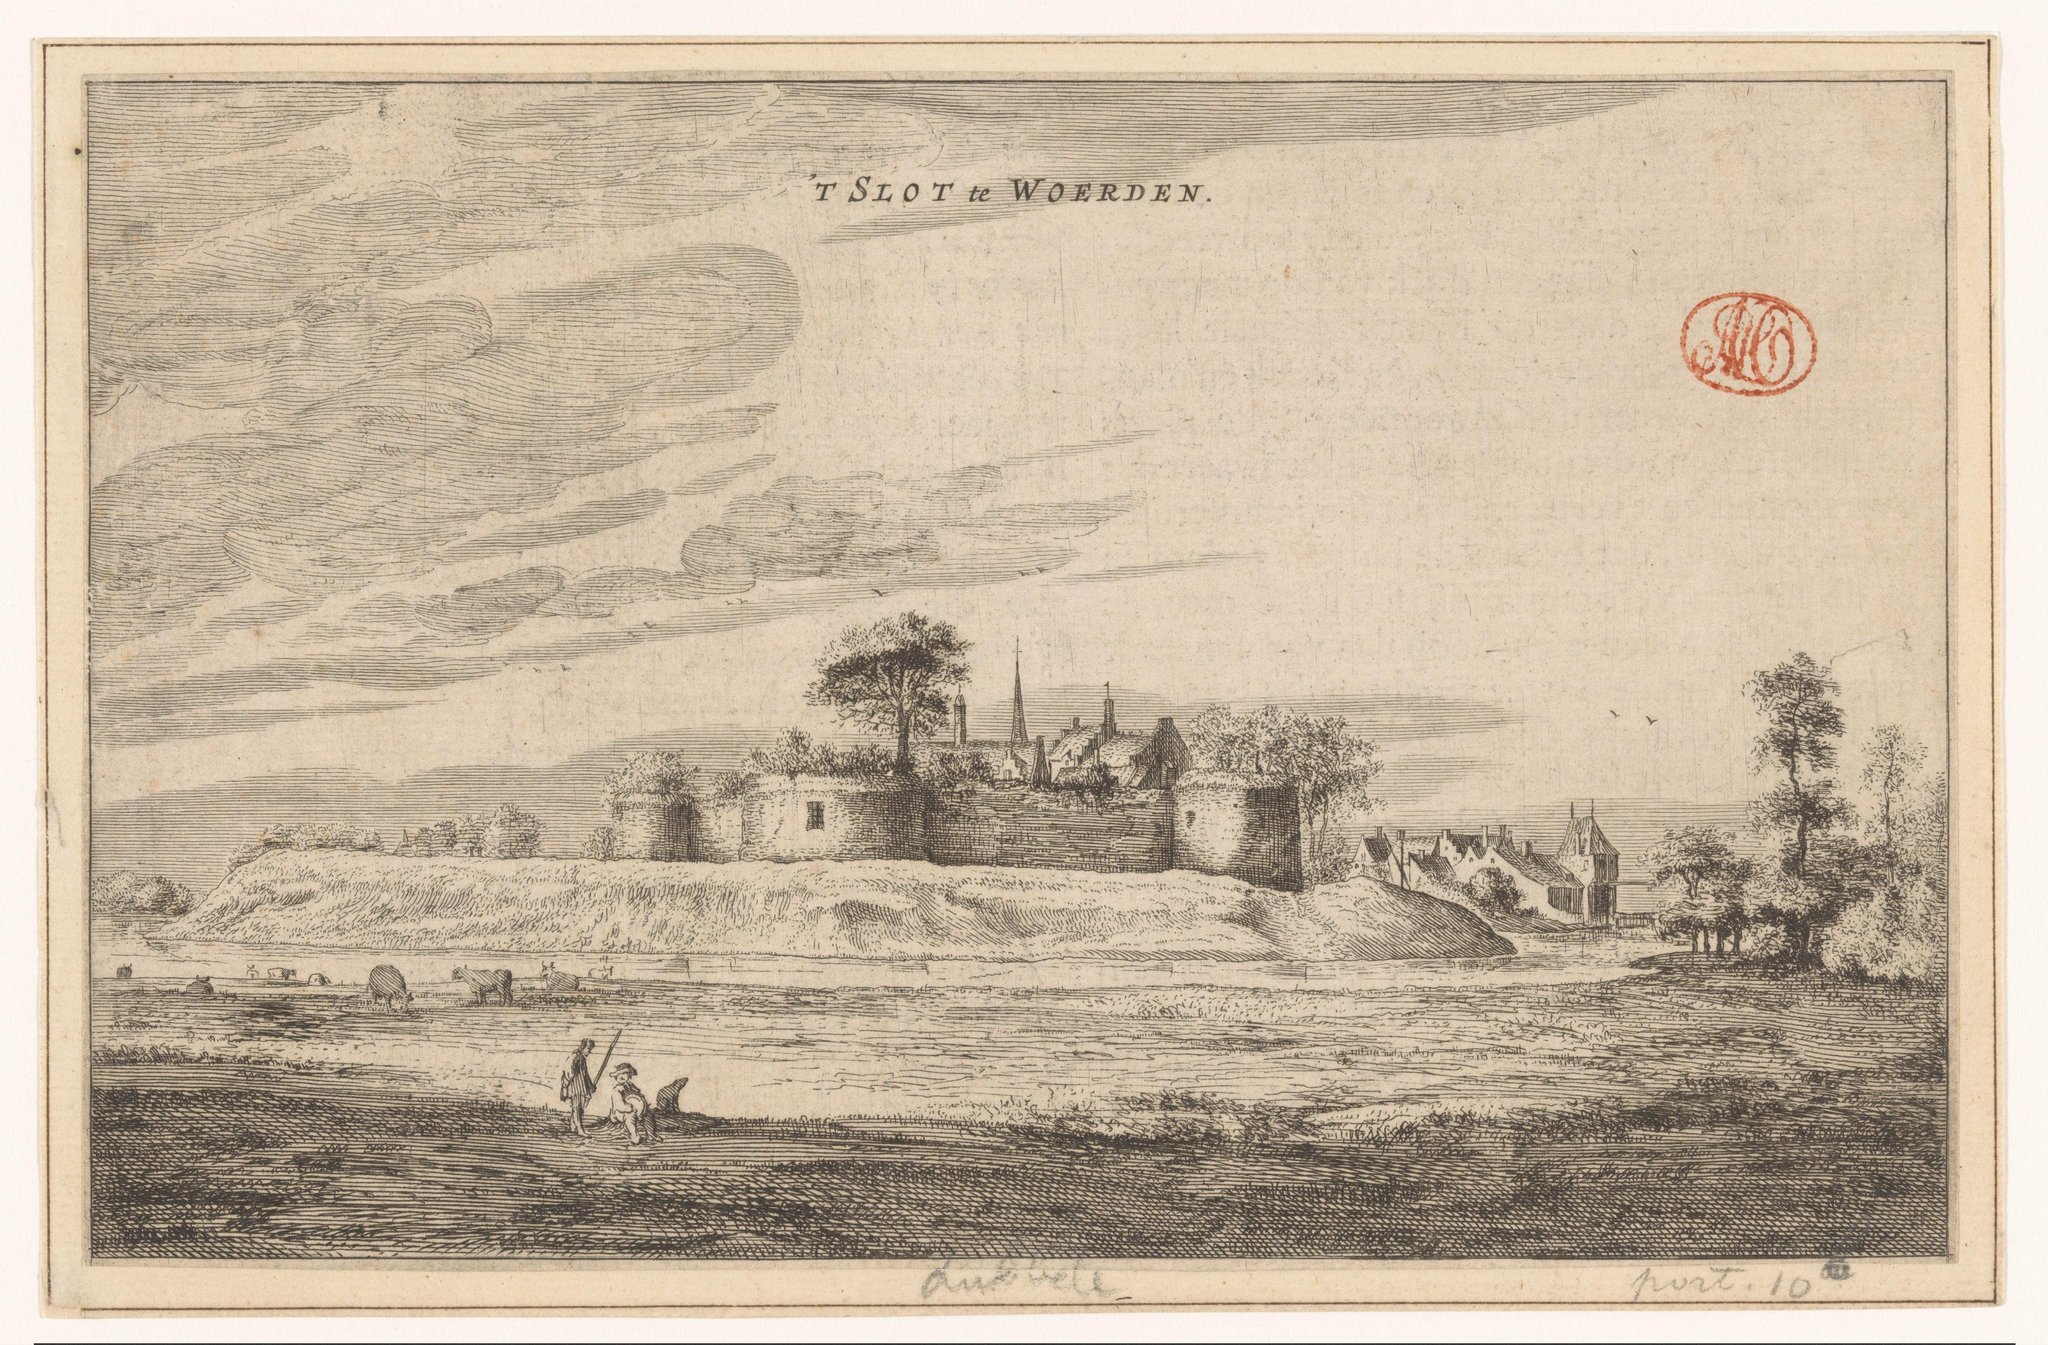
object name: print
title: 't Slot te Woerden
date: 1652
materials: paper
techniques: engraving, etching, letterpress printing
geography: amsterdam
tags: castle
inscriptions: collector's mark: Lugt 195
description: Prent gebruikt in: Blaeu, Johannes Willemszoon. Toonneel der steden van de Vereenighde Nederlanden. 2 delen. Amsterdam: Johannes Willemszoon Blaeu, 1652, dl. 1.